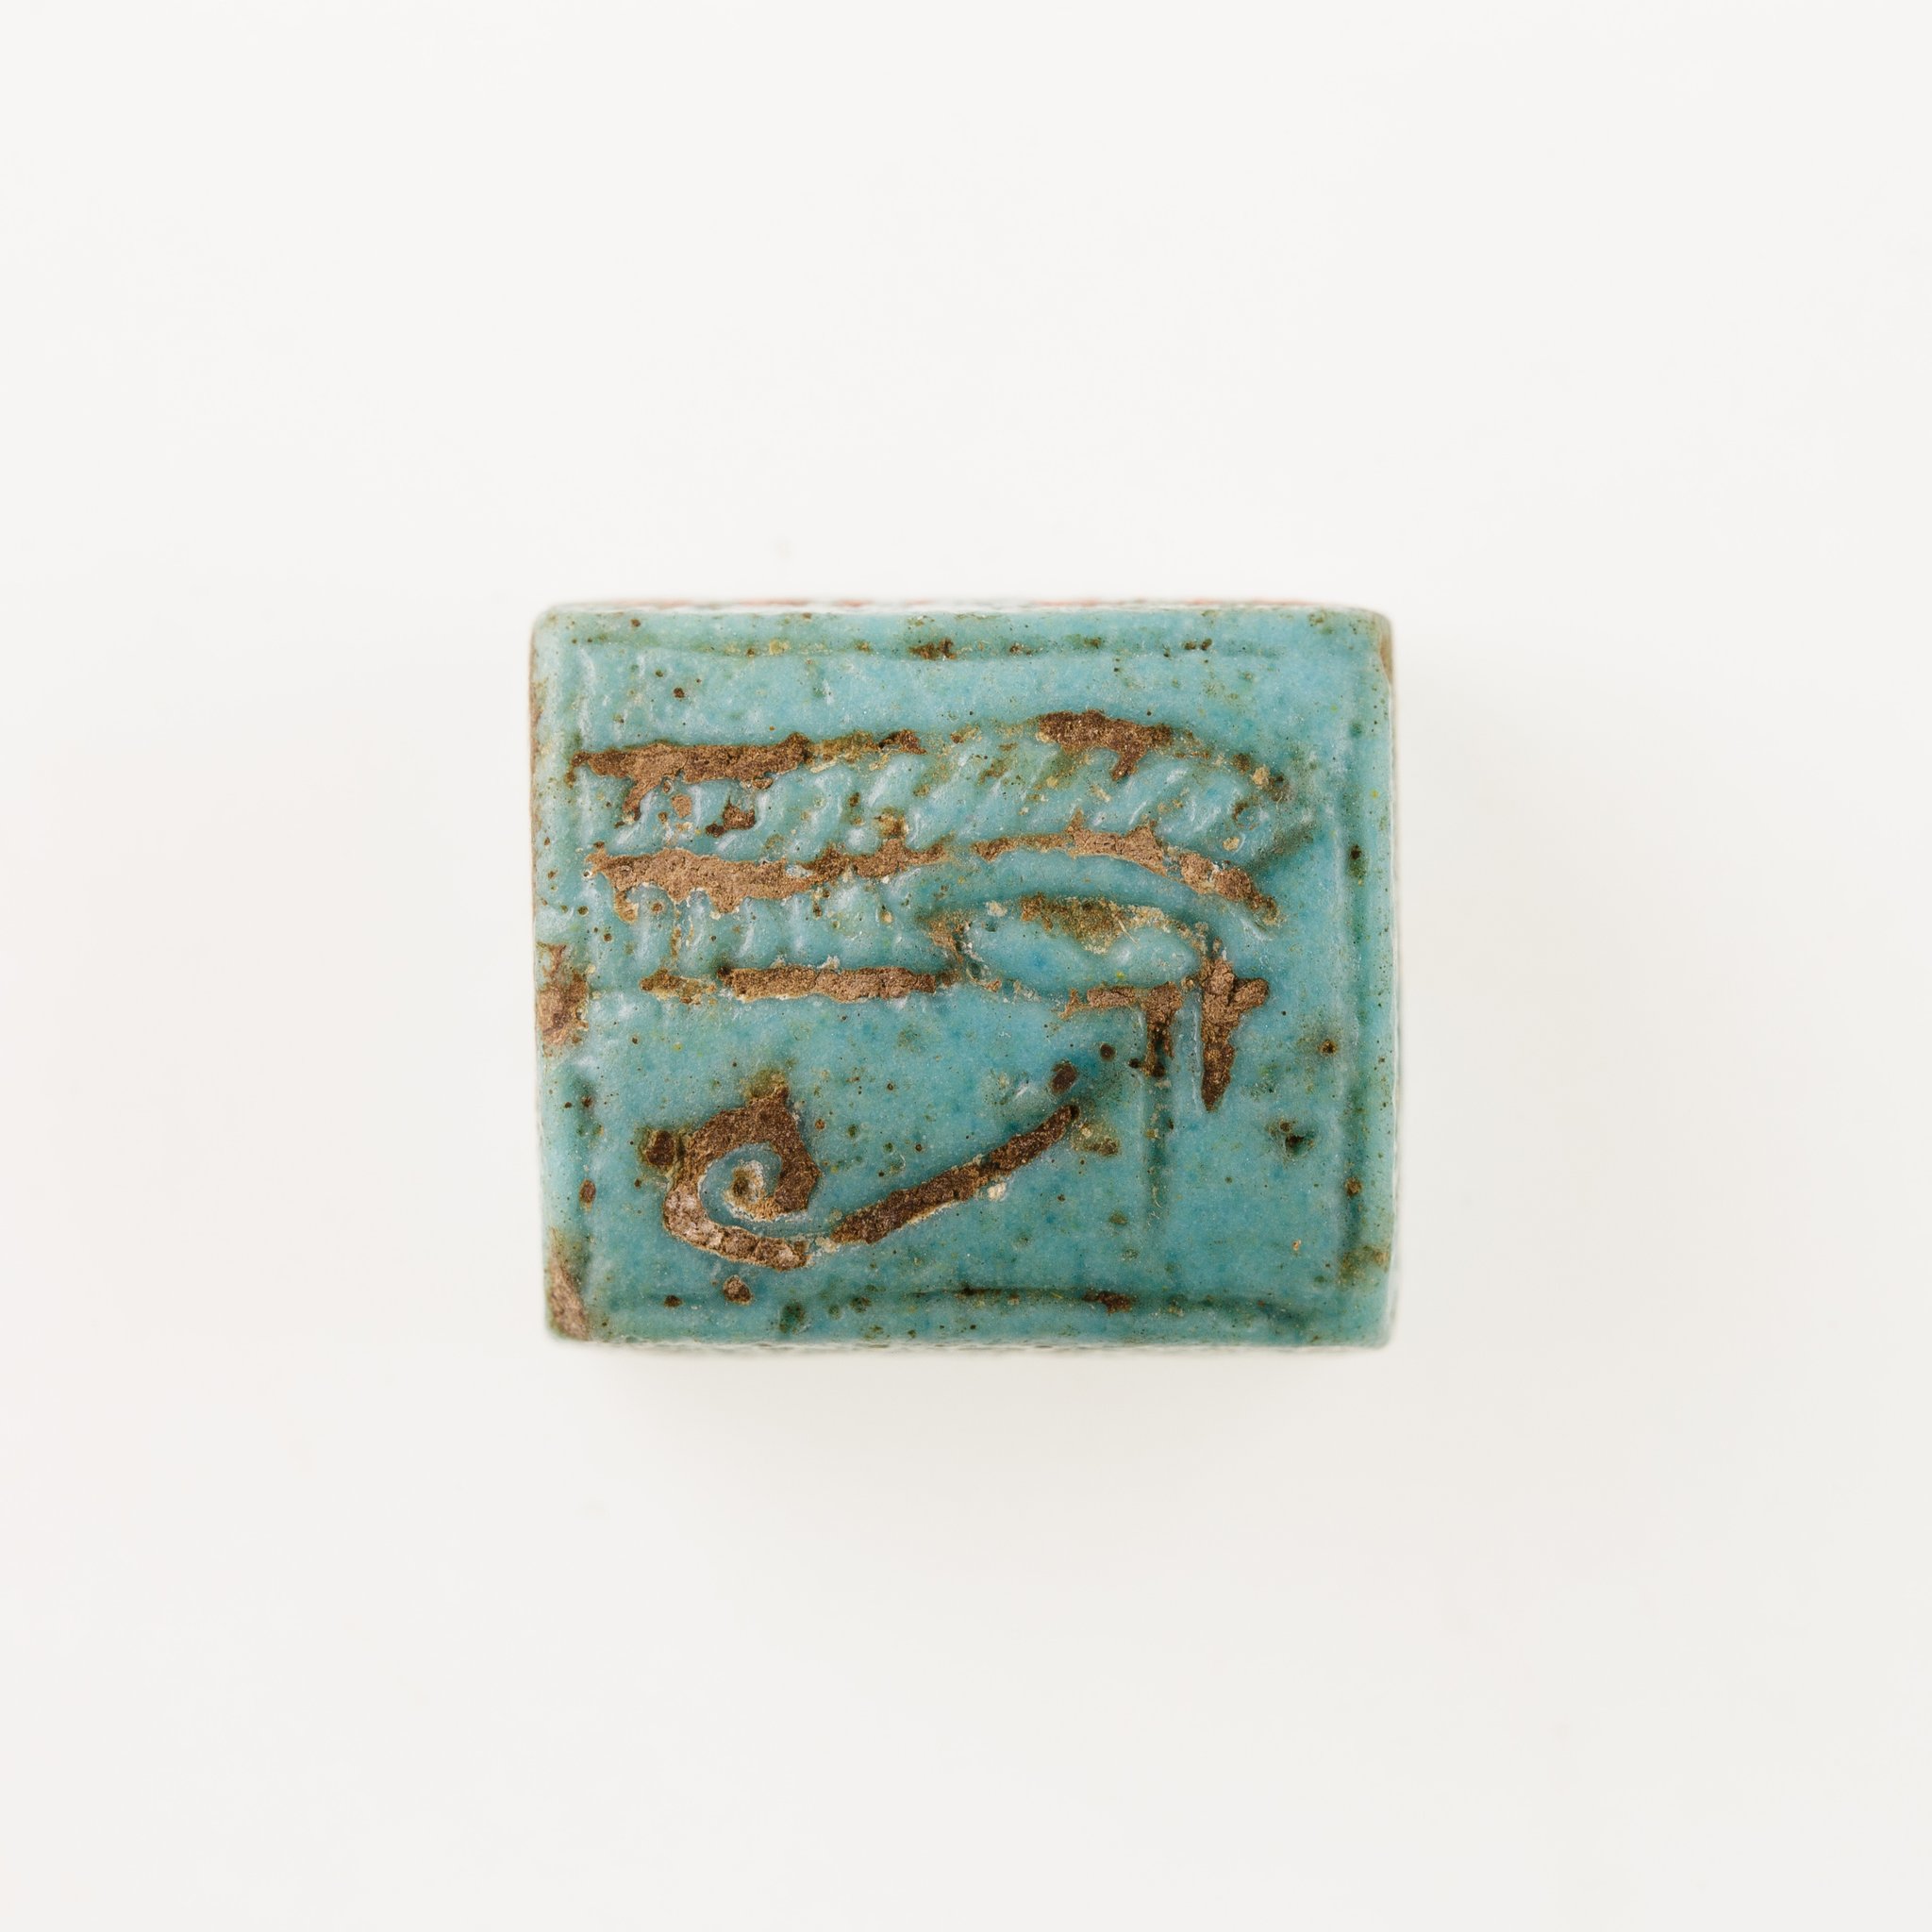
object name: amulet, wedjat eye, tiye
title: Wedjat Eye Amulet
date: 1070-343 BCE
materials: faience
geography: egypt